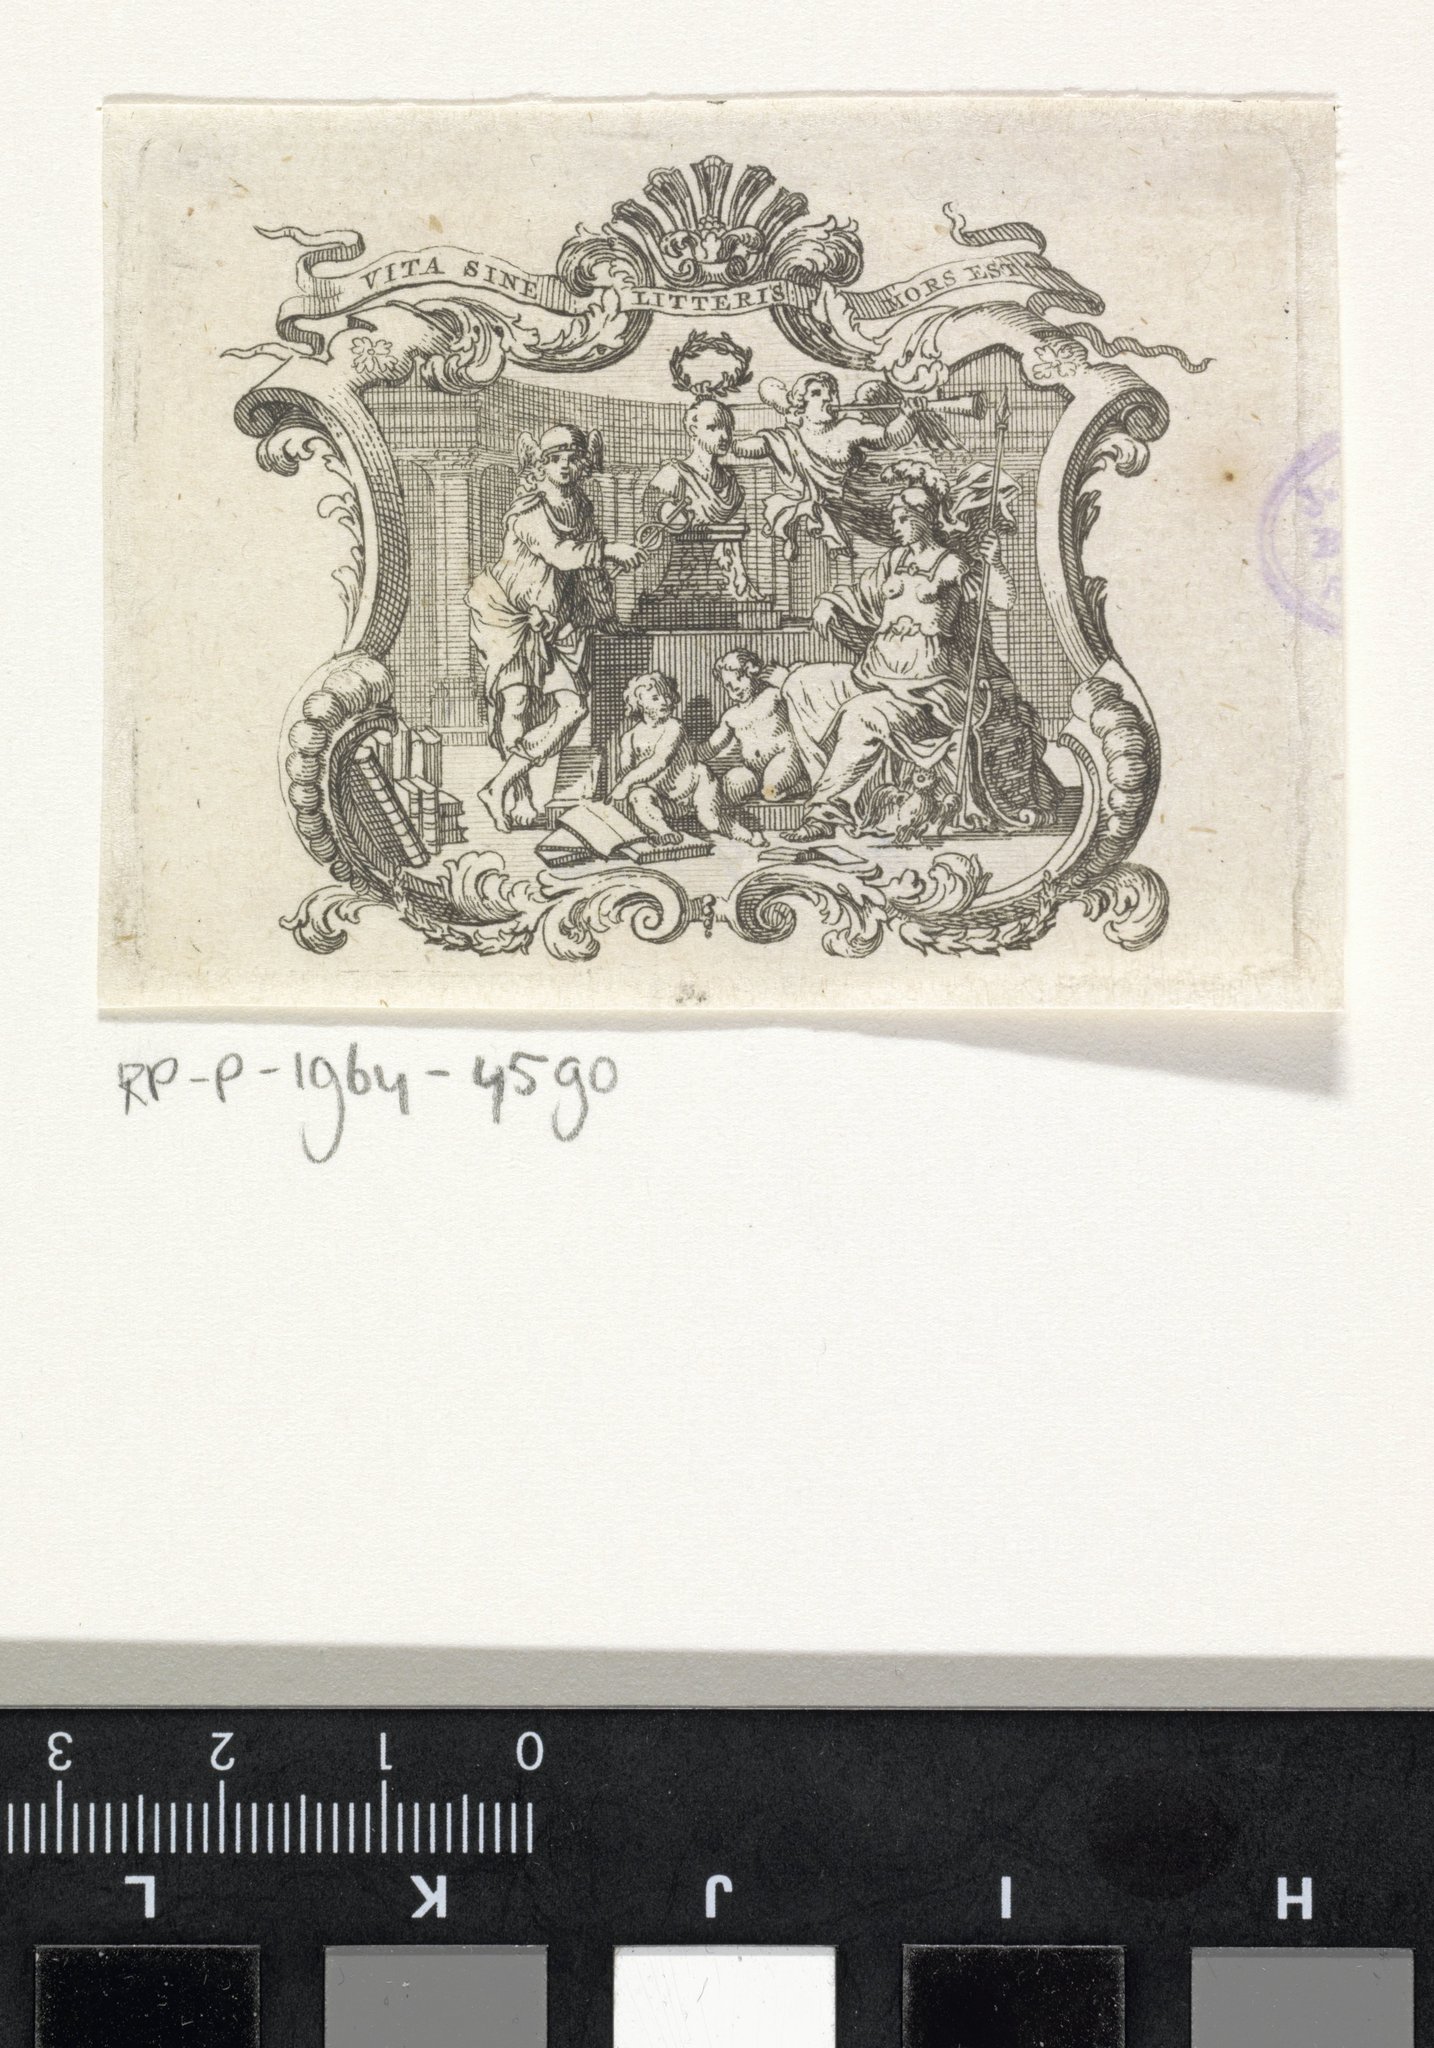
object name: print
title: Vignet met Minerva en Mercurius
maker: Anonymous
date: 1700-1800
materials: paper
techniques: etching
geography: netherlands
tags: (story of) minerva (pallas, athena), (story of) mercury (hermes)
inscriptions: collector's mark: Lugt 2228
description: Cartouche met Minerva en Mercurius bij de buste van een man, die door Faam met een laurierkrans wordt gekroond. Geheel boven het devies: Vita sine litteris mors est (Een leven zonder leren is dood).